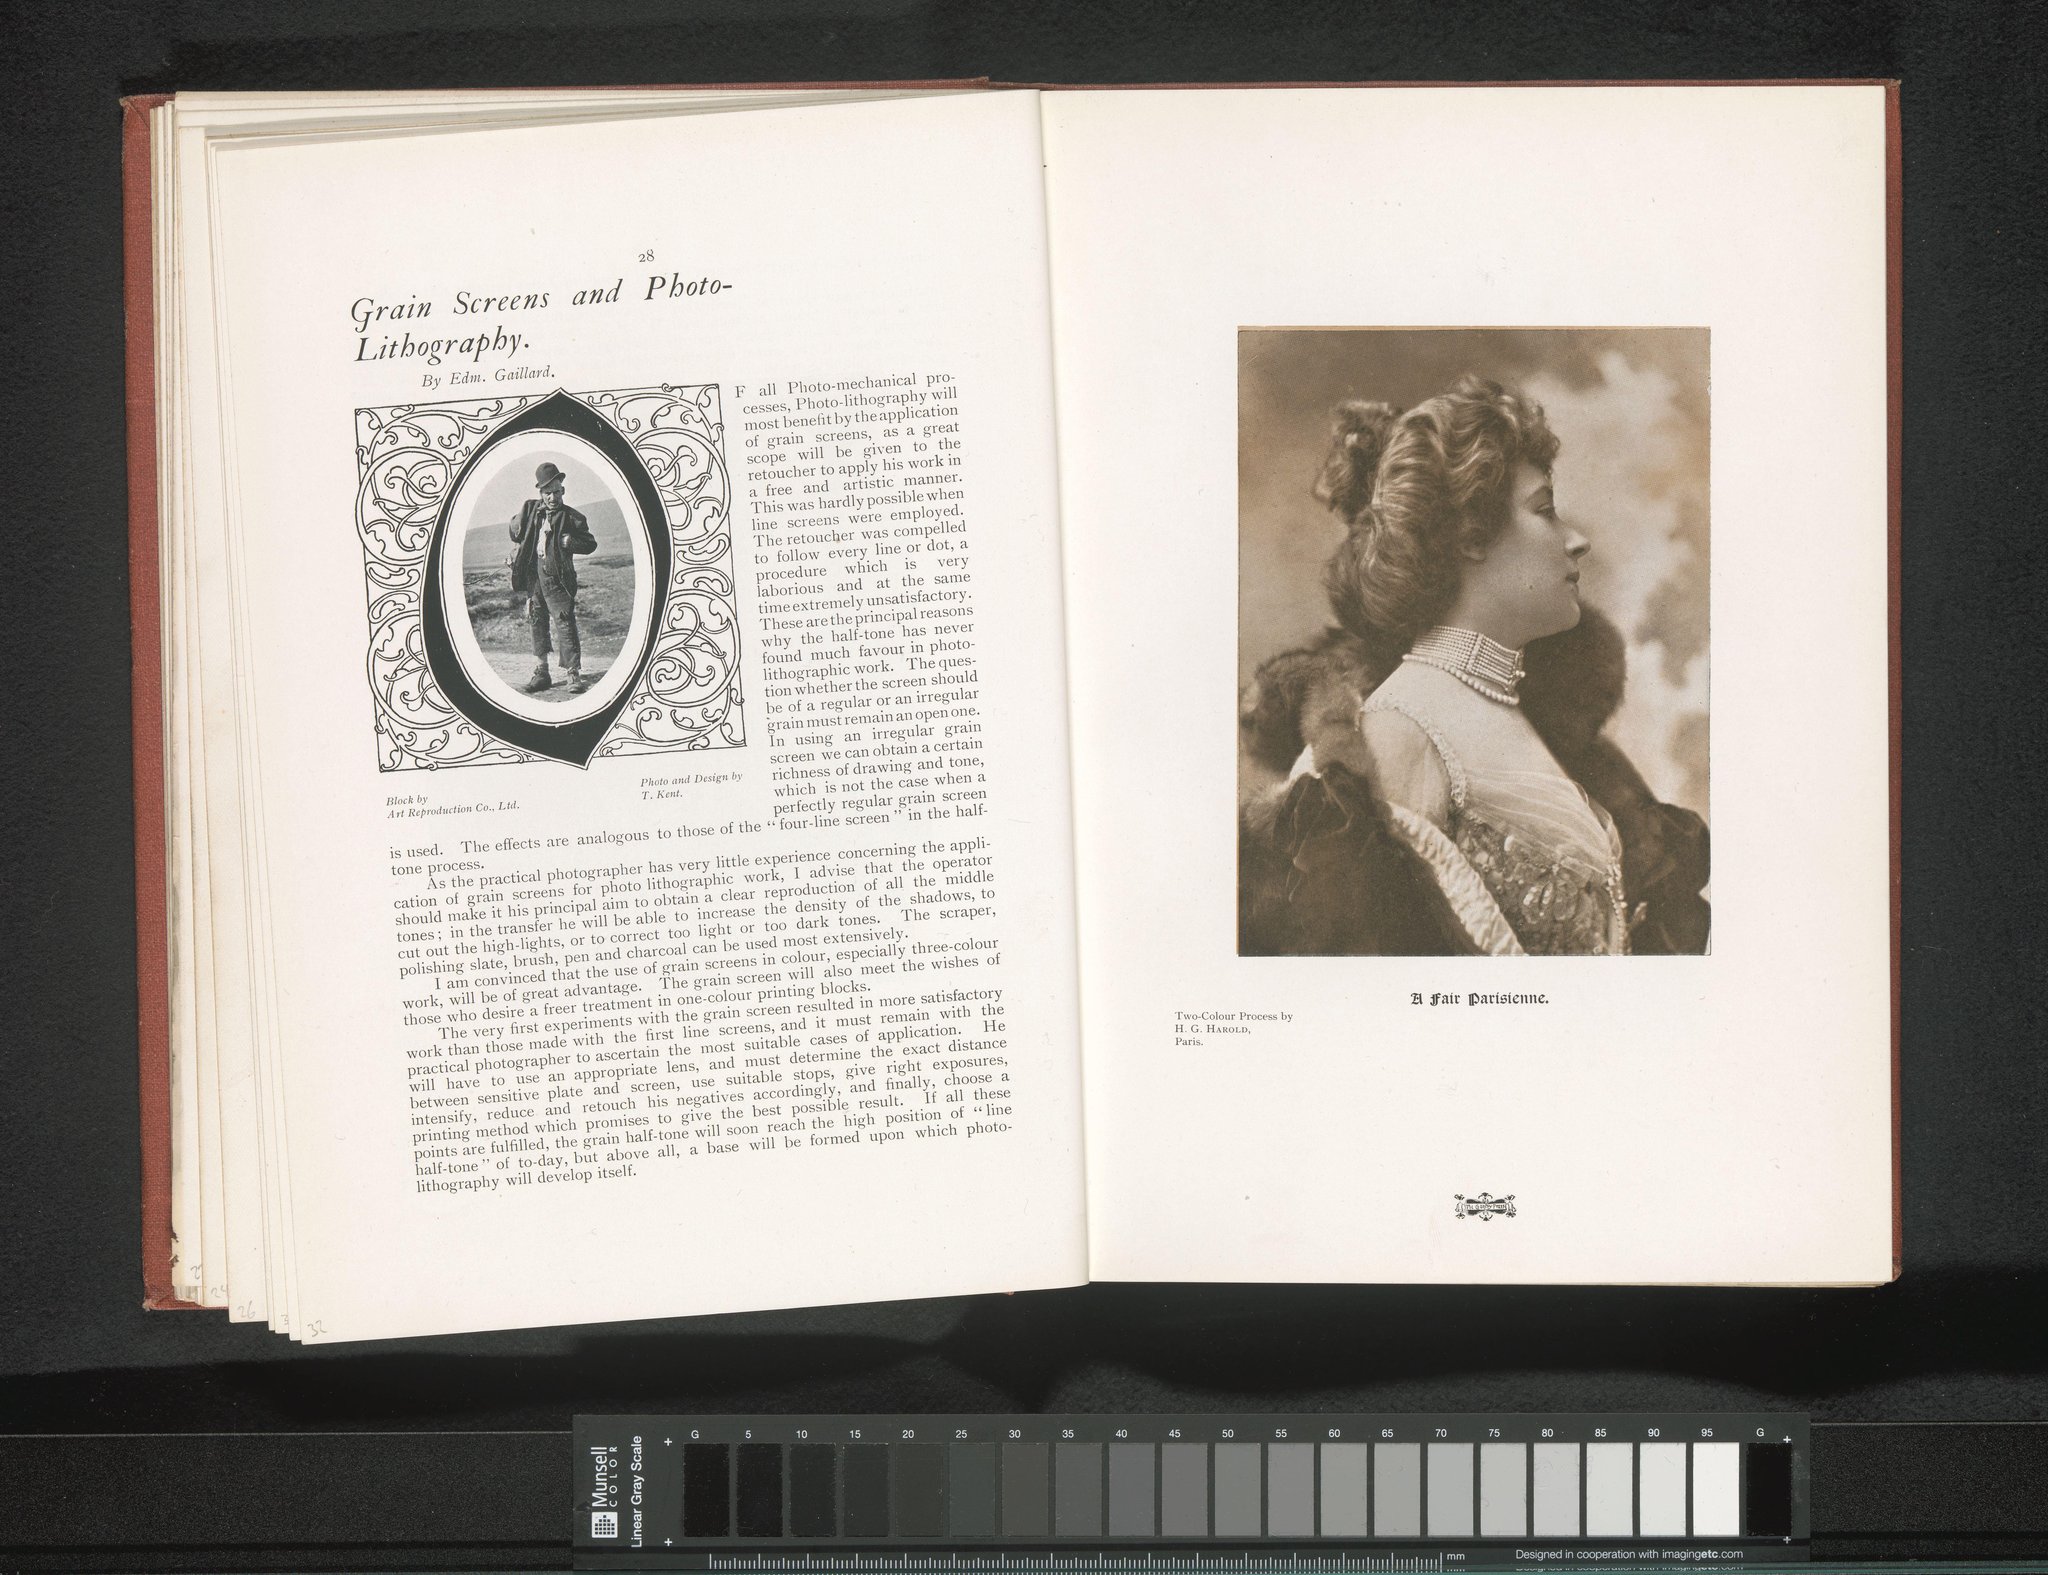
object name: photomechanical print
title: A fair Parisienne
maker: h.g. harold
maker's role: printer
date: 1895-1900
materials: paper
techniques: two-color autotype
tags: historical persons - bb - woman